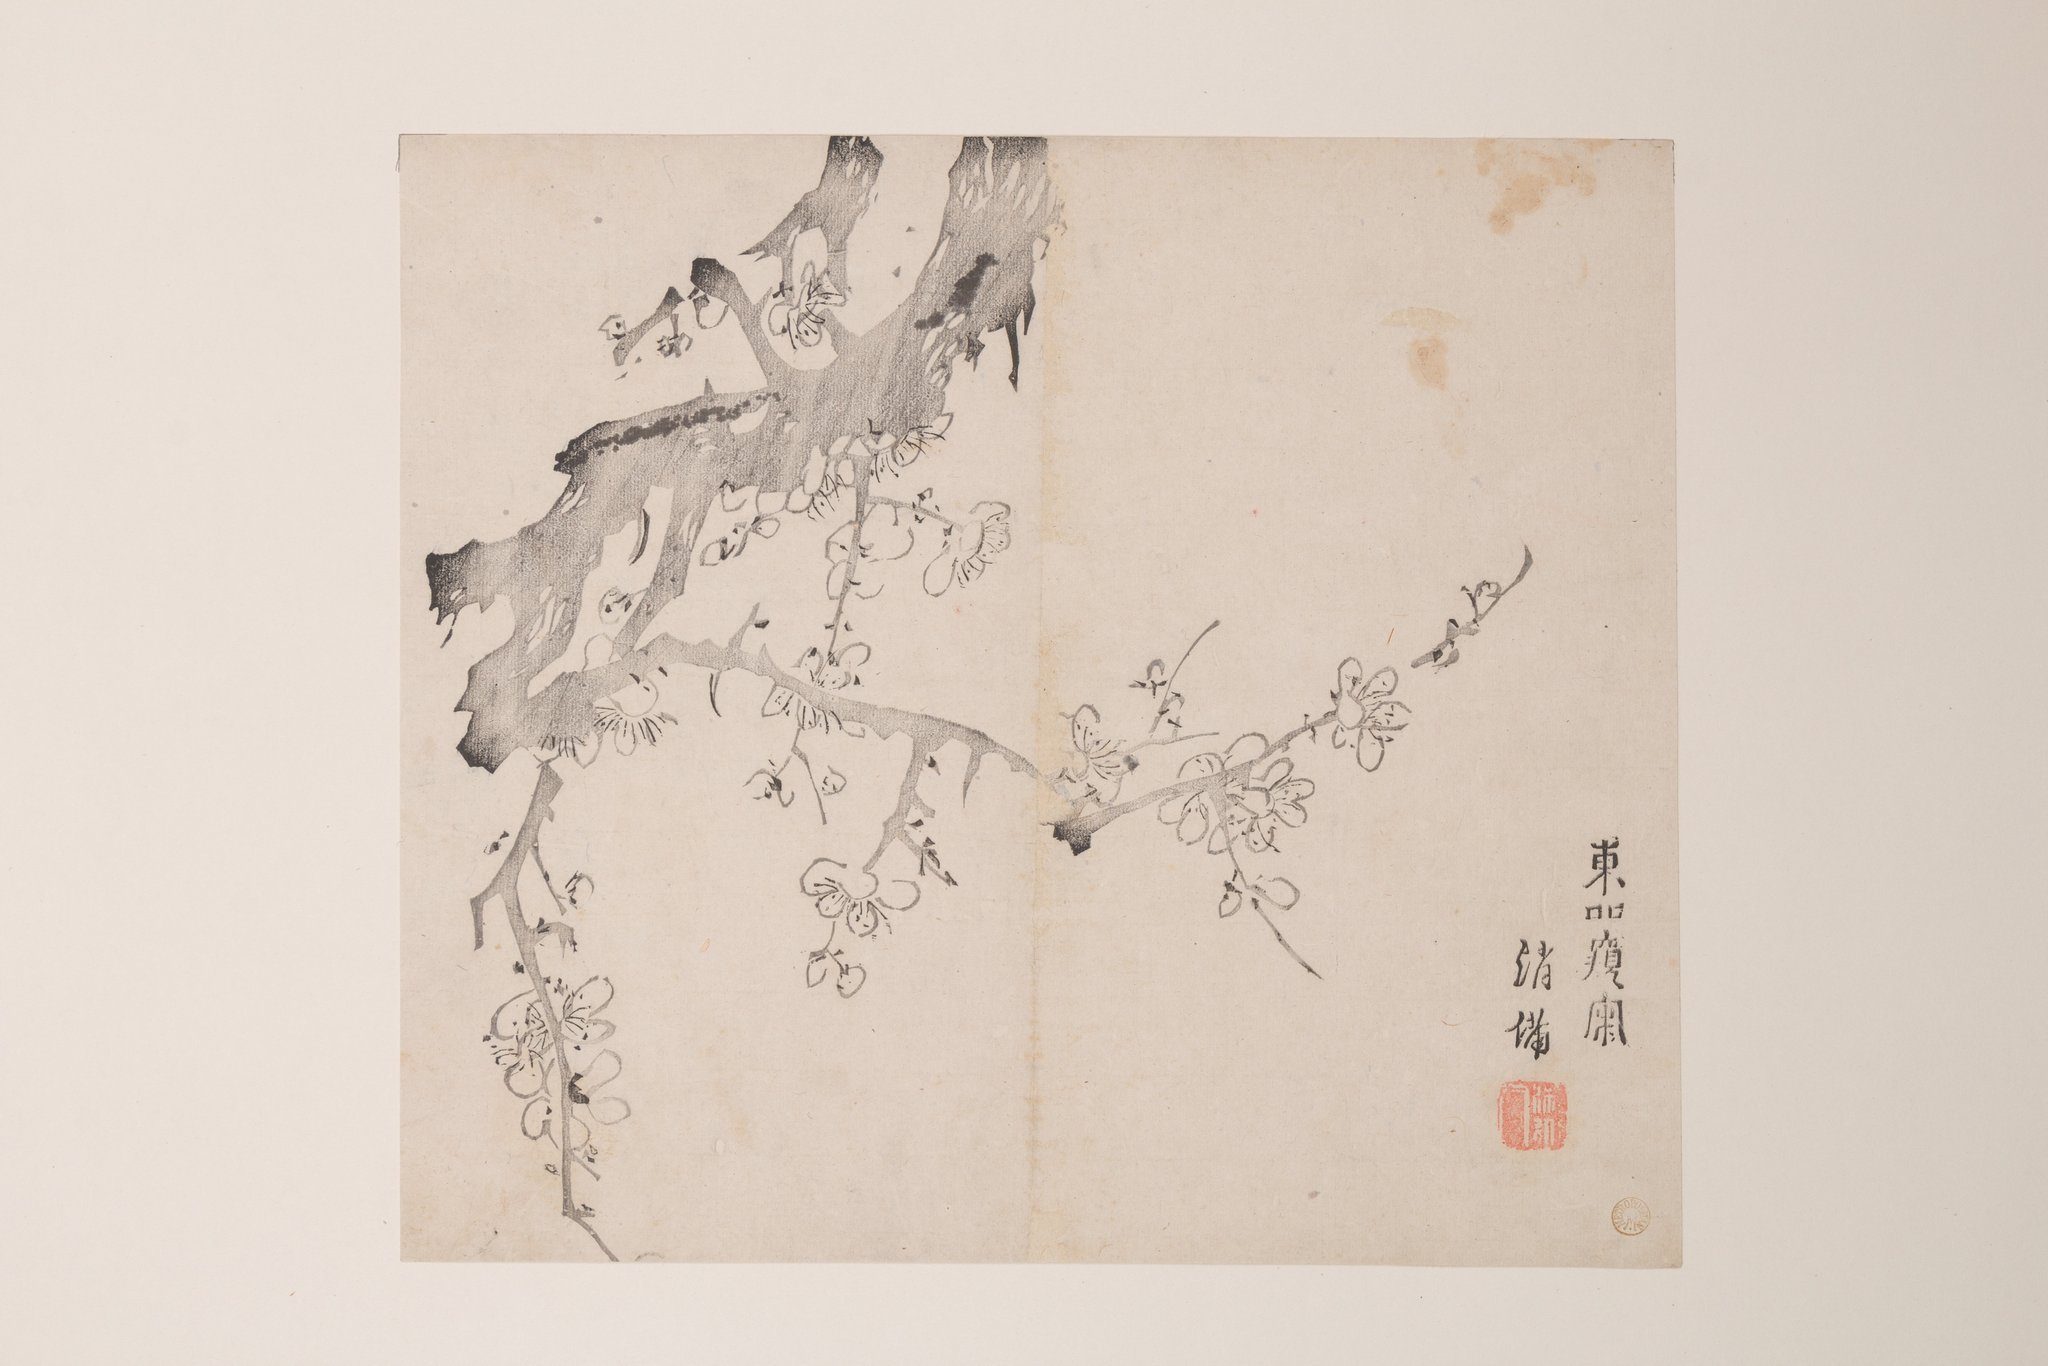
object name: print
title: Page from Shi Zhu Zhai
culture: chinese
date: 1662-1722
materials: ink, paper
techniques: polychrome, woodblock print